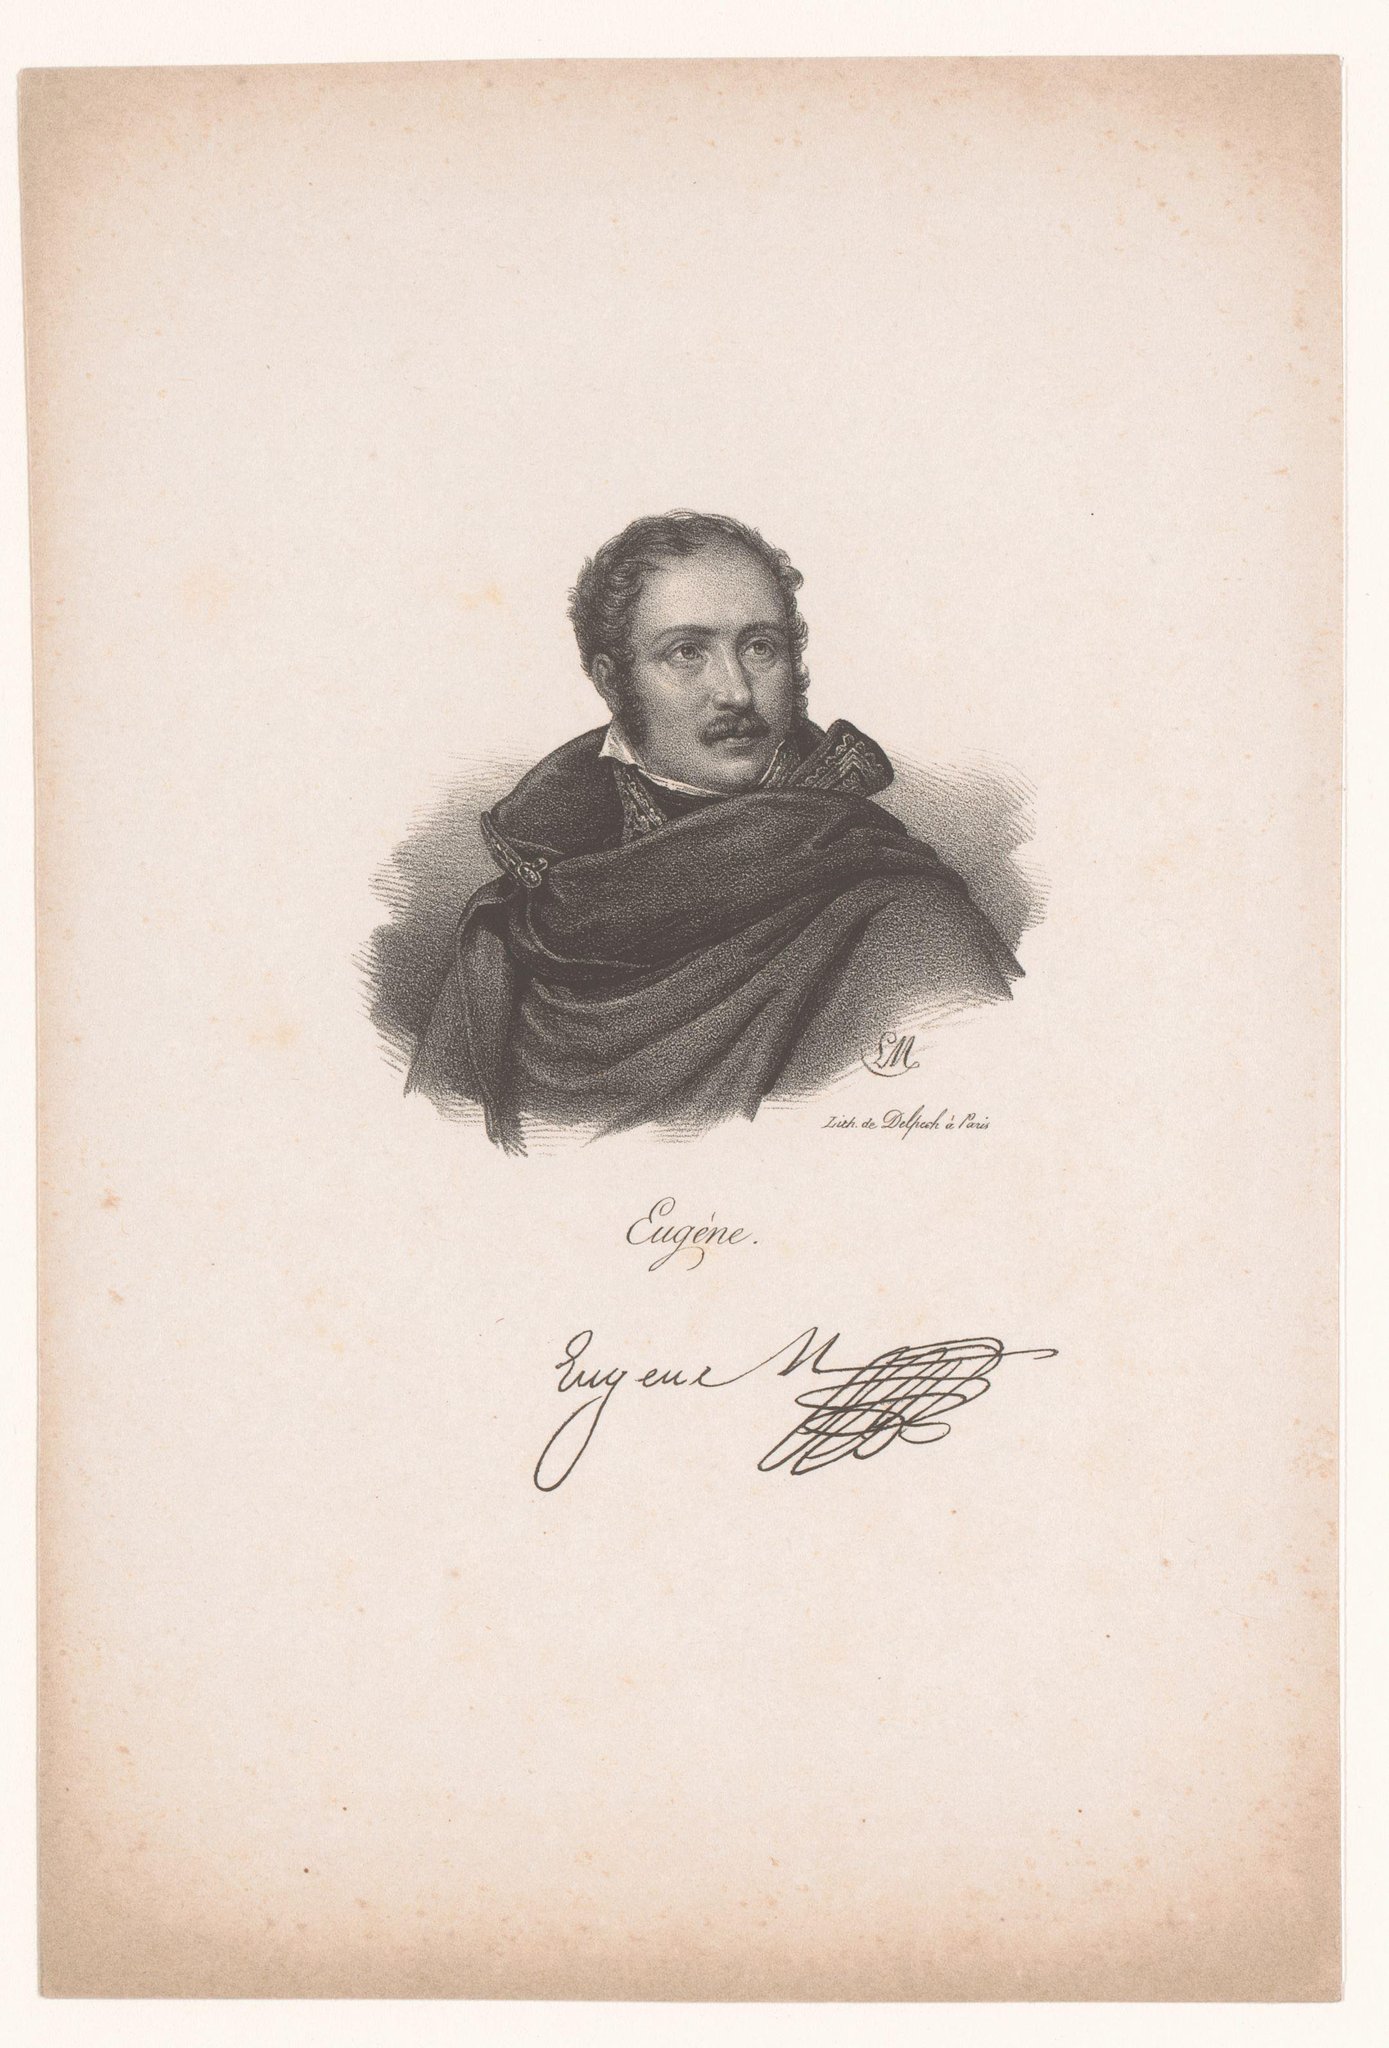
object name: print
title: Portret van Eugène de Beauharnais, hertog van Leuchtenberg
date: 1825-1842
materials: paper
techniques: lithograph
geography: paris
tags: paris, eugène de beauharnais, historical persons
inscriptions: collector's mark: Lugt 2228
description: Prent waarschijnlijk gebruikt voor: Célébrités contemporaines ou portraits des personnes de notre époque (…). Parijs: veuve Delpech, 1842. En/of voor: Célébrités contemporaines ou portraits des personnes de notre époque (…). Parijs: Rosselin, 1845-1849. Mogelijk komt de prent ook voor in eerdere en/of latere publicaties uitgegeven door veuve Delpech of haar opvolger Rosselin.